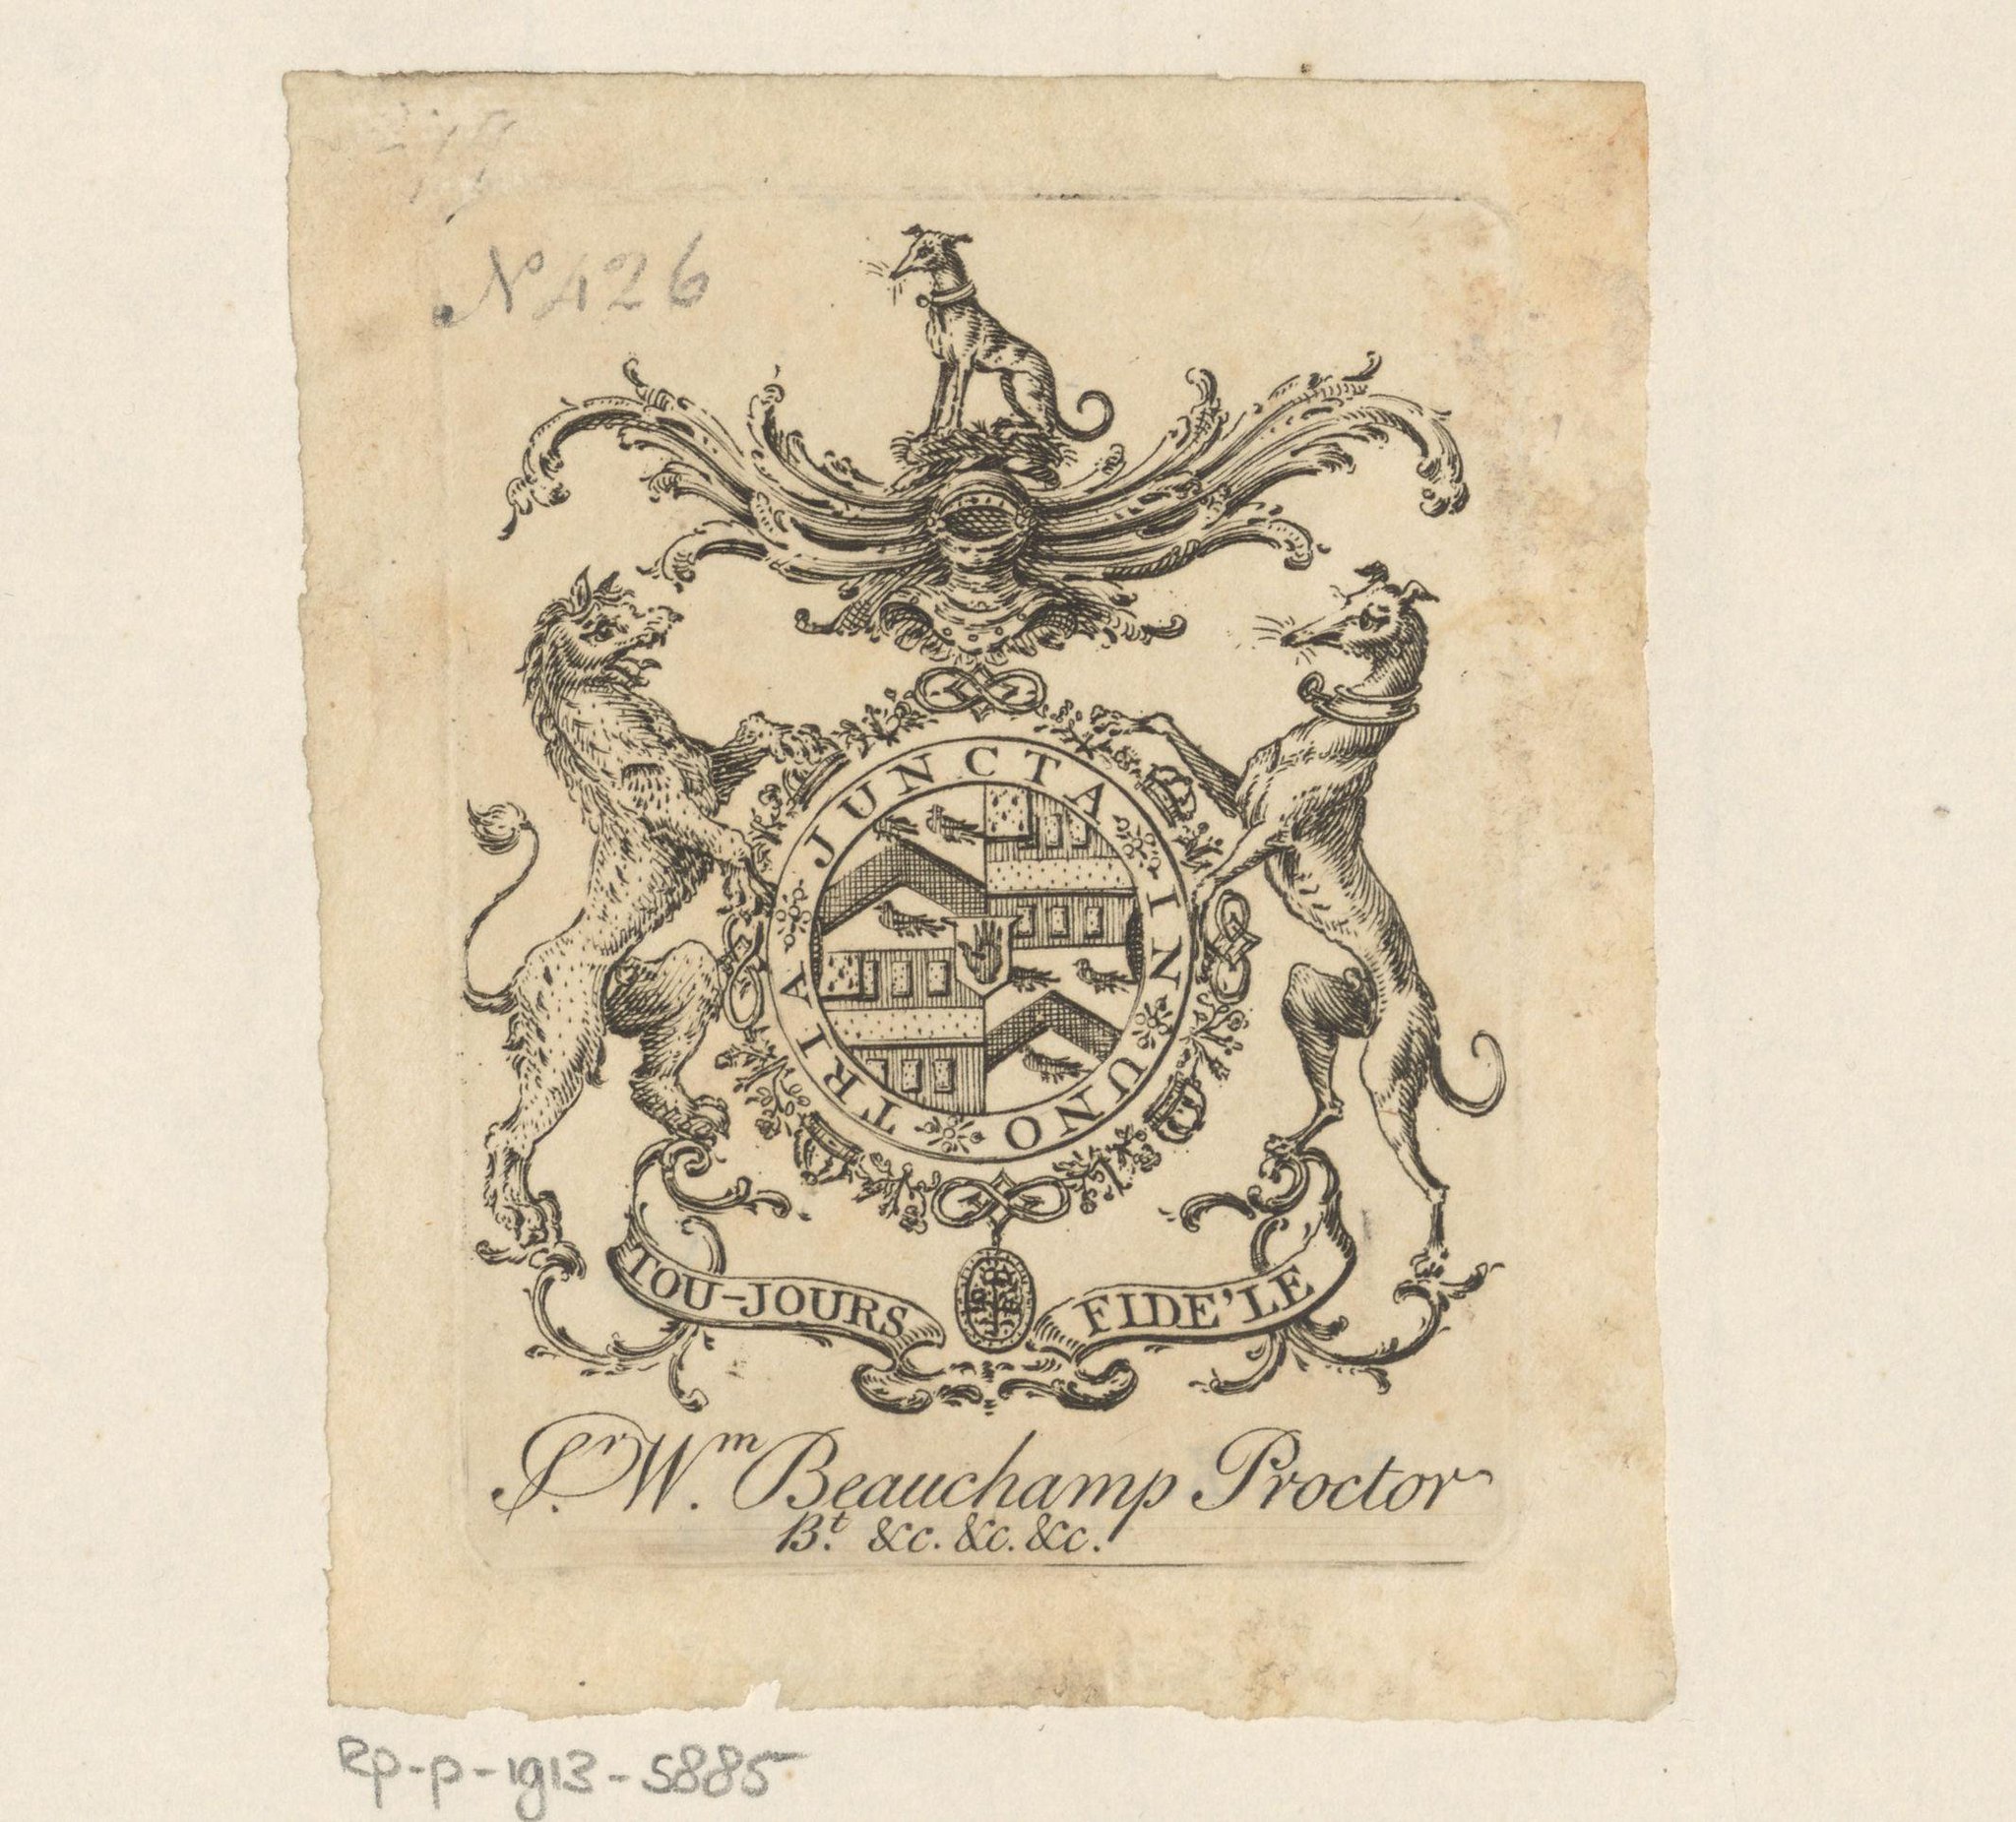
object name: bookplate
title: Ex libris van Sr. Wm. Beauchamp Proctor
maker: Anonymous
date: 1791-1861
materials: paper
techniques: engraving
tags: armorial bearing, heraldry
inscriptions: collector's mark: Lugt 2760, collector's mark: Lugt 2233